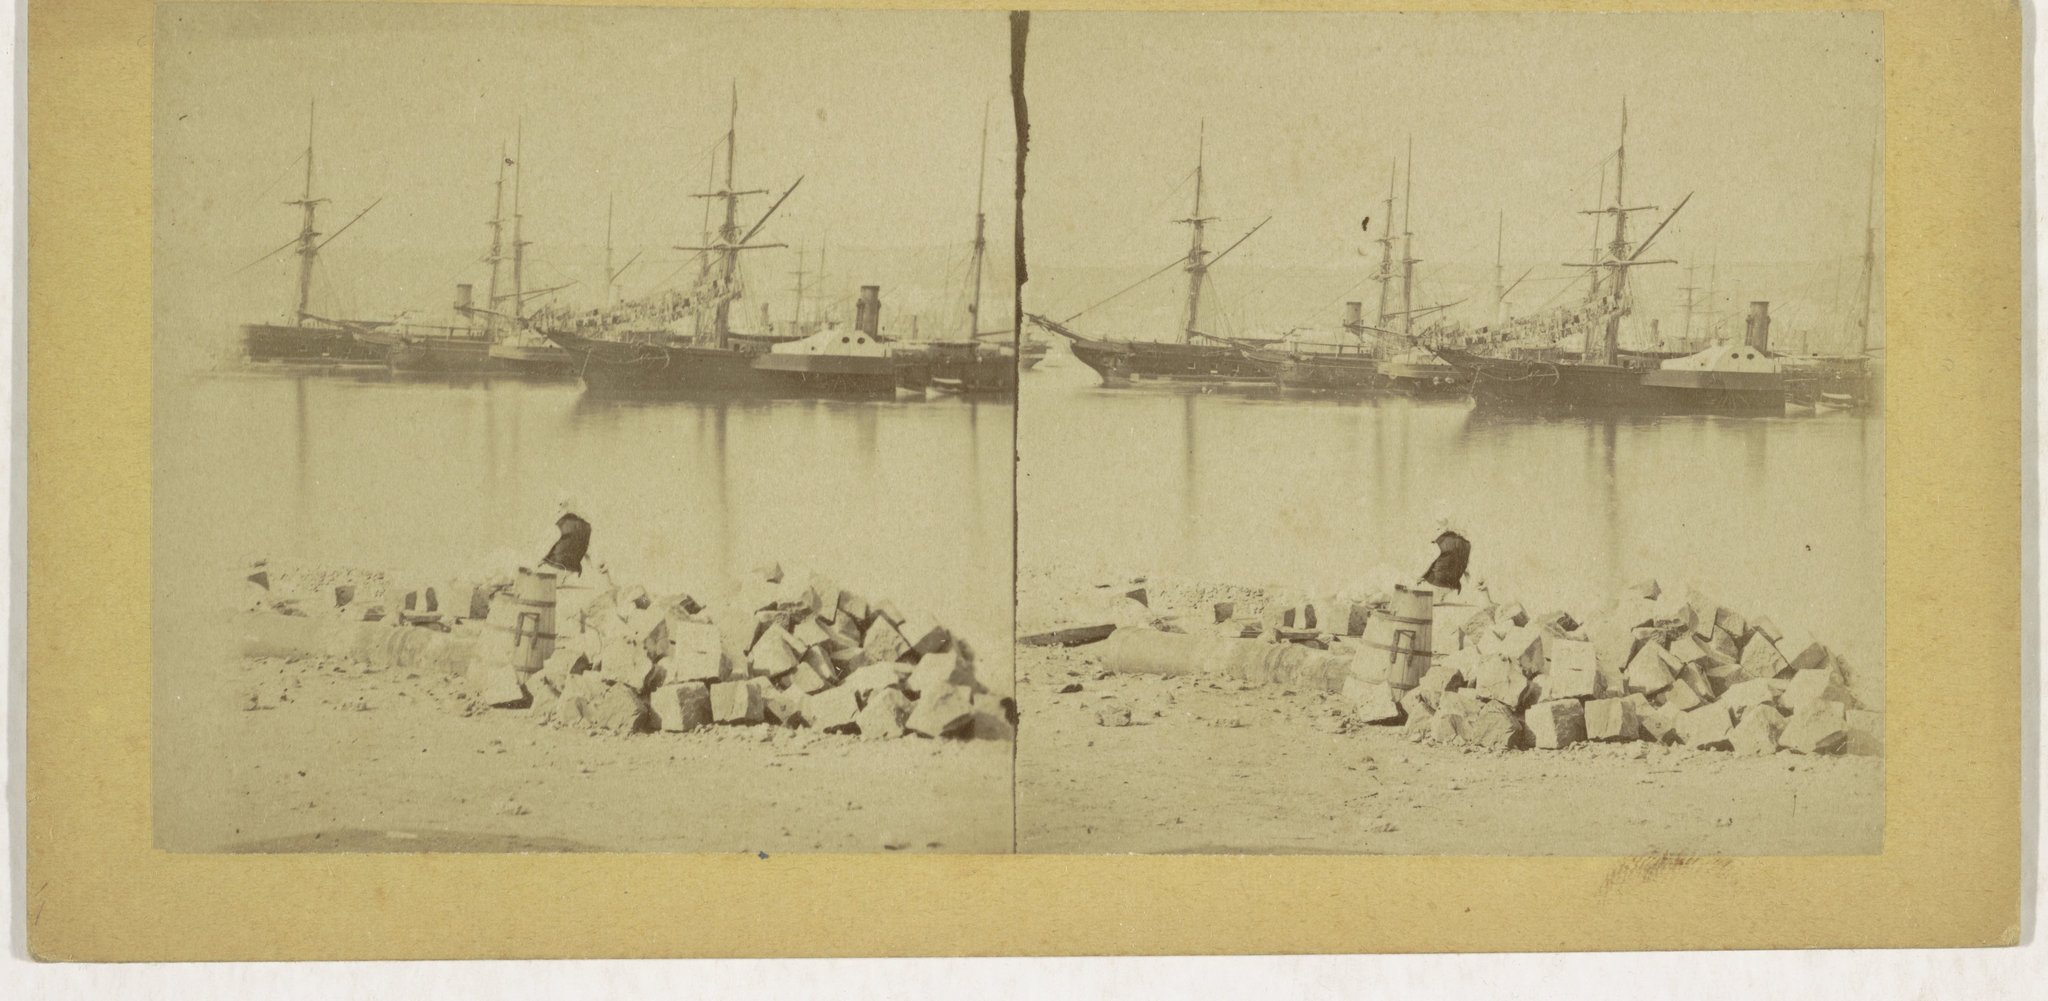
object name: stereograph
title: Alger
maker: Anonymous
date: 1857-1863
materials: cardboard, paper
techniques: albumen print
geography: algiers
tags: harbour